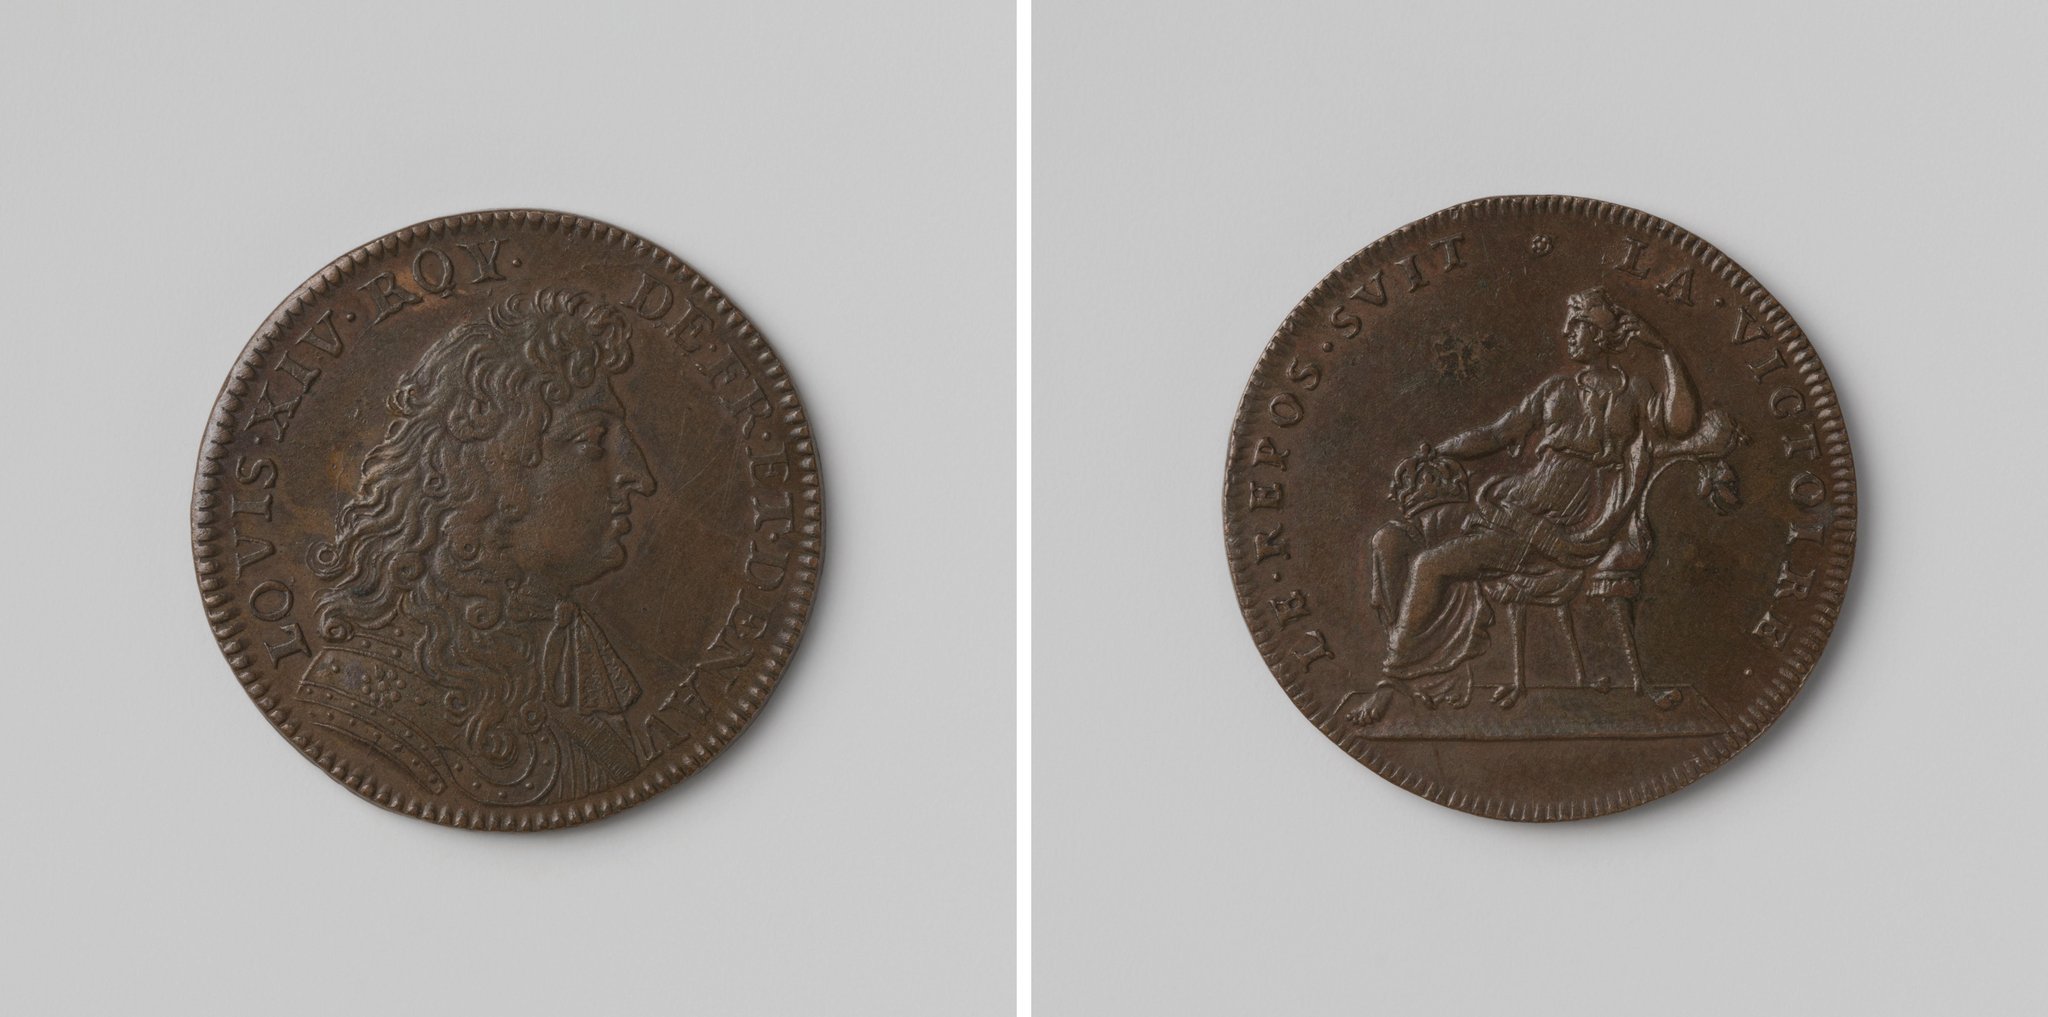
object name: jeton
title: Twintigjarige bestand van Regensburg tussen Frankrijk, de Keizer, Spanje en de Nederlanden, rekenpenning geslagen ter ere van Lodewijk XIV, koning van Frankrijk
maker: Anonymous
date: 1684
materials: copper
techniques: striking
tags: lodewijk xiv (koning van frankrijk)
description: Koperen penning. Voorzijde: borststuk man binnen omschrift. Keerzijde: zittende vrouw, voorstellende de Rust, houdt kroon op haar knie binnen omschrift